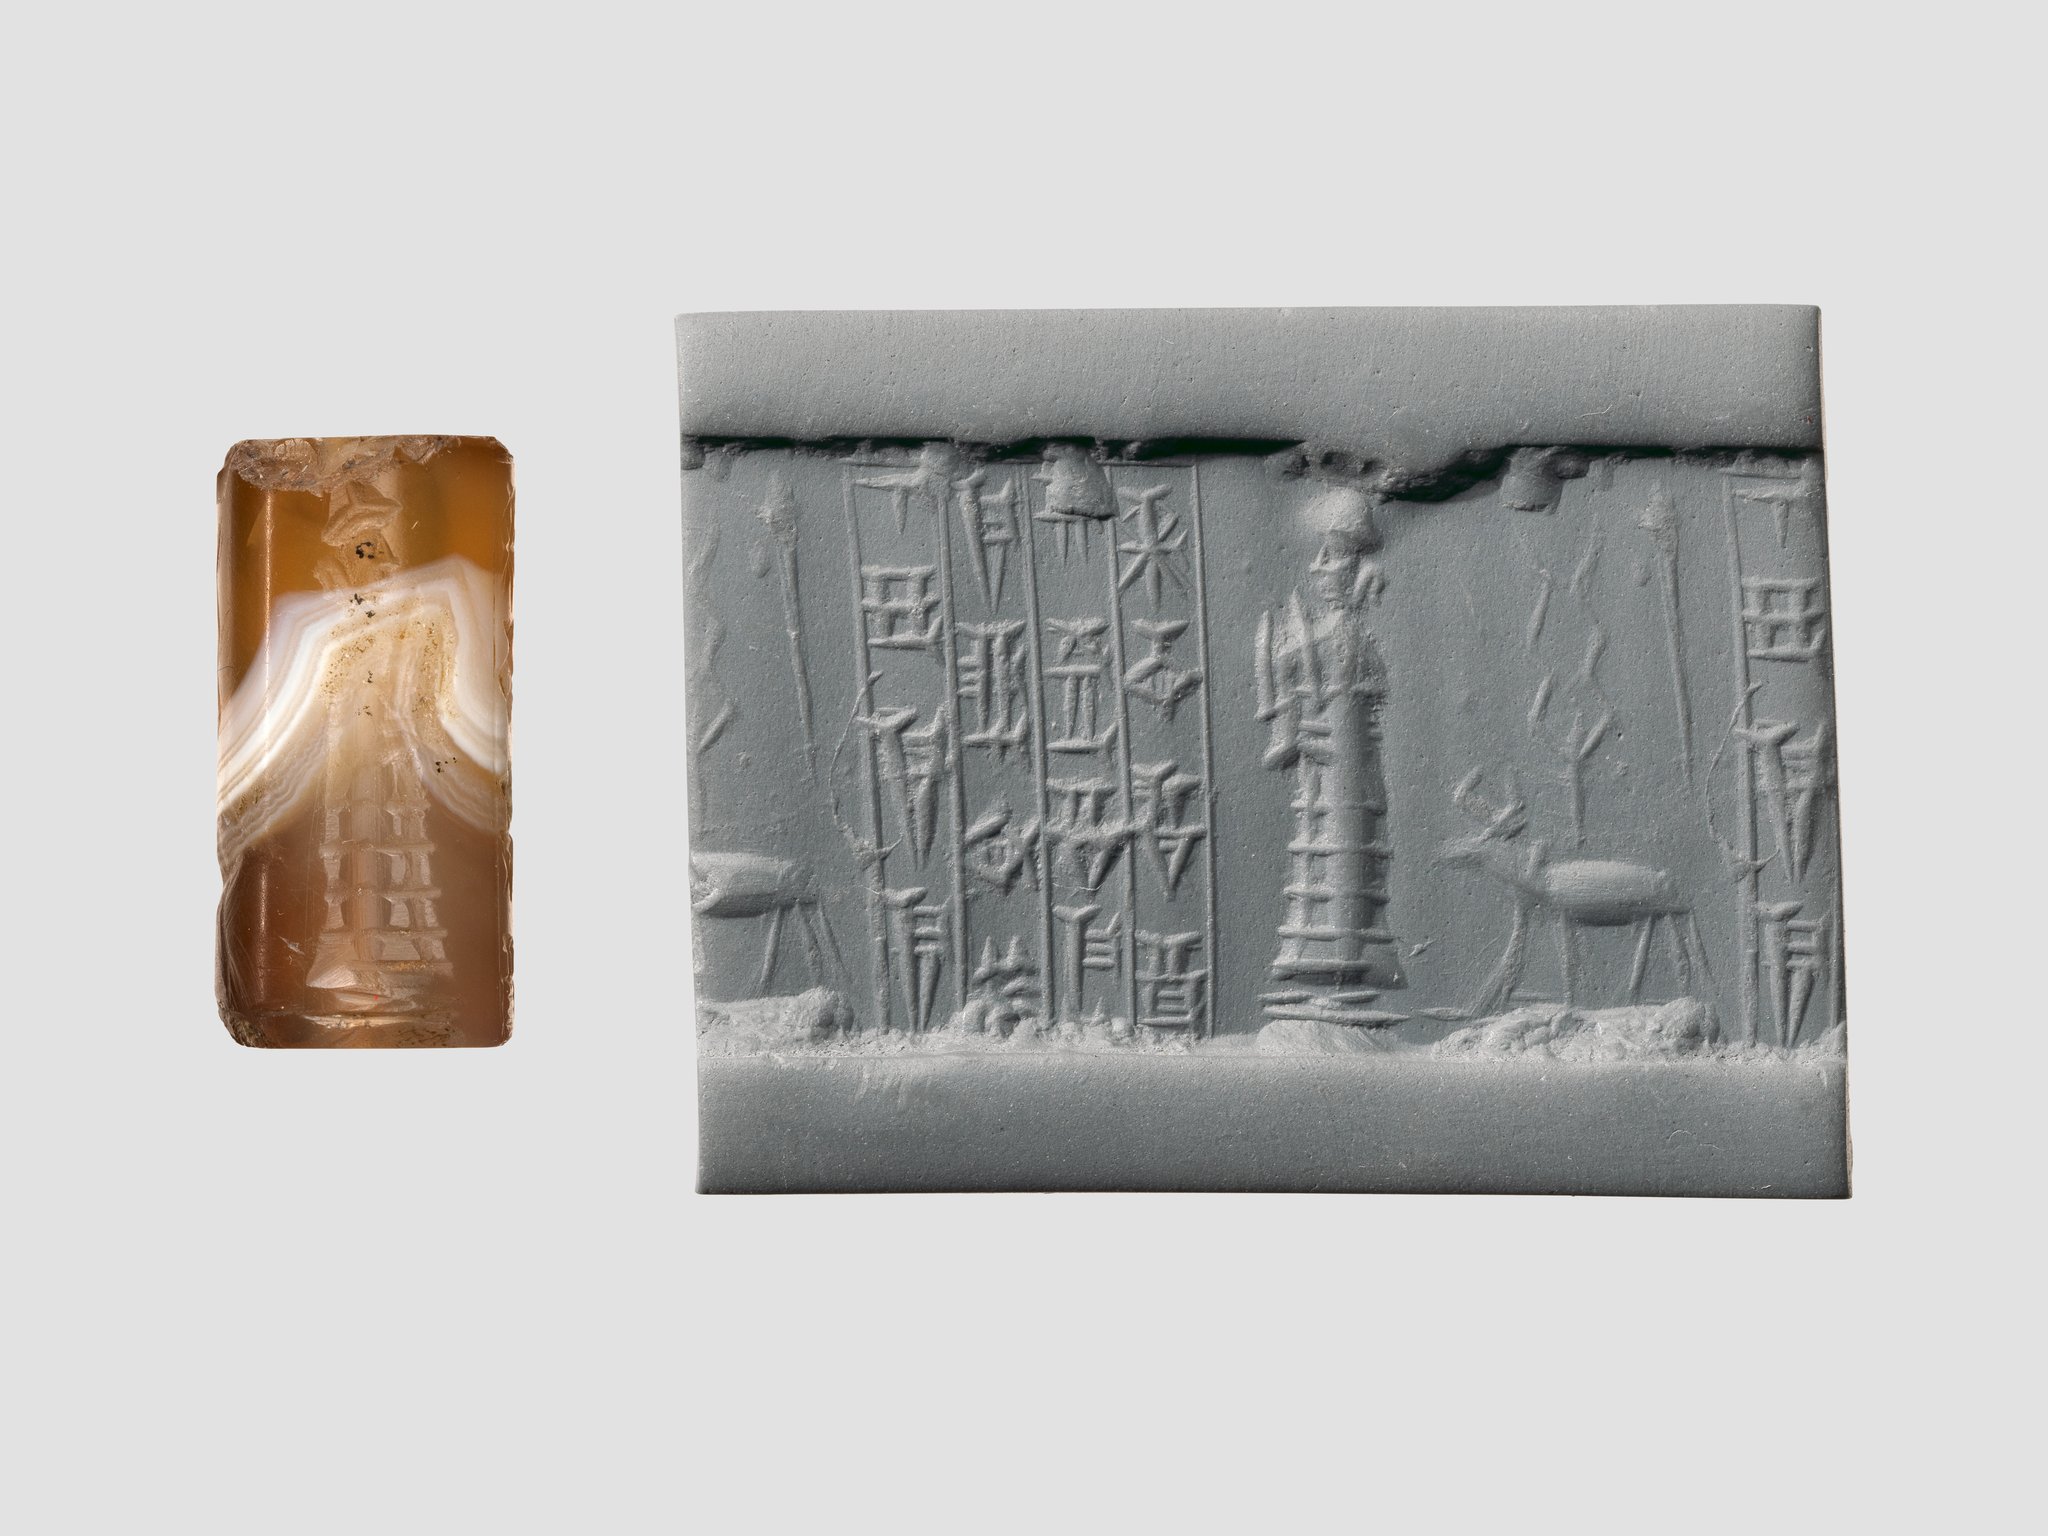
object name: cylinder seal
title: Cylinder seal and modern impression: suppliant goddess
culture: babylonian or kassite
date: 1700-1501 BCE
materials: stone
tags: animals,goddess